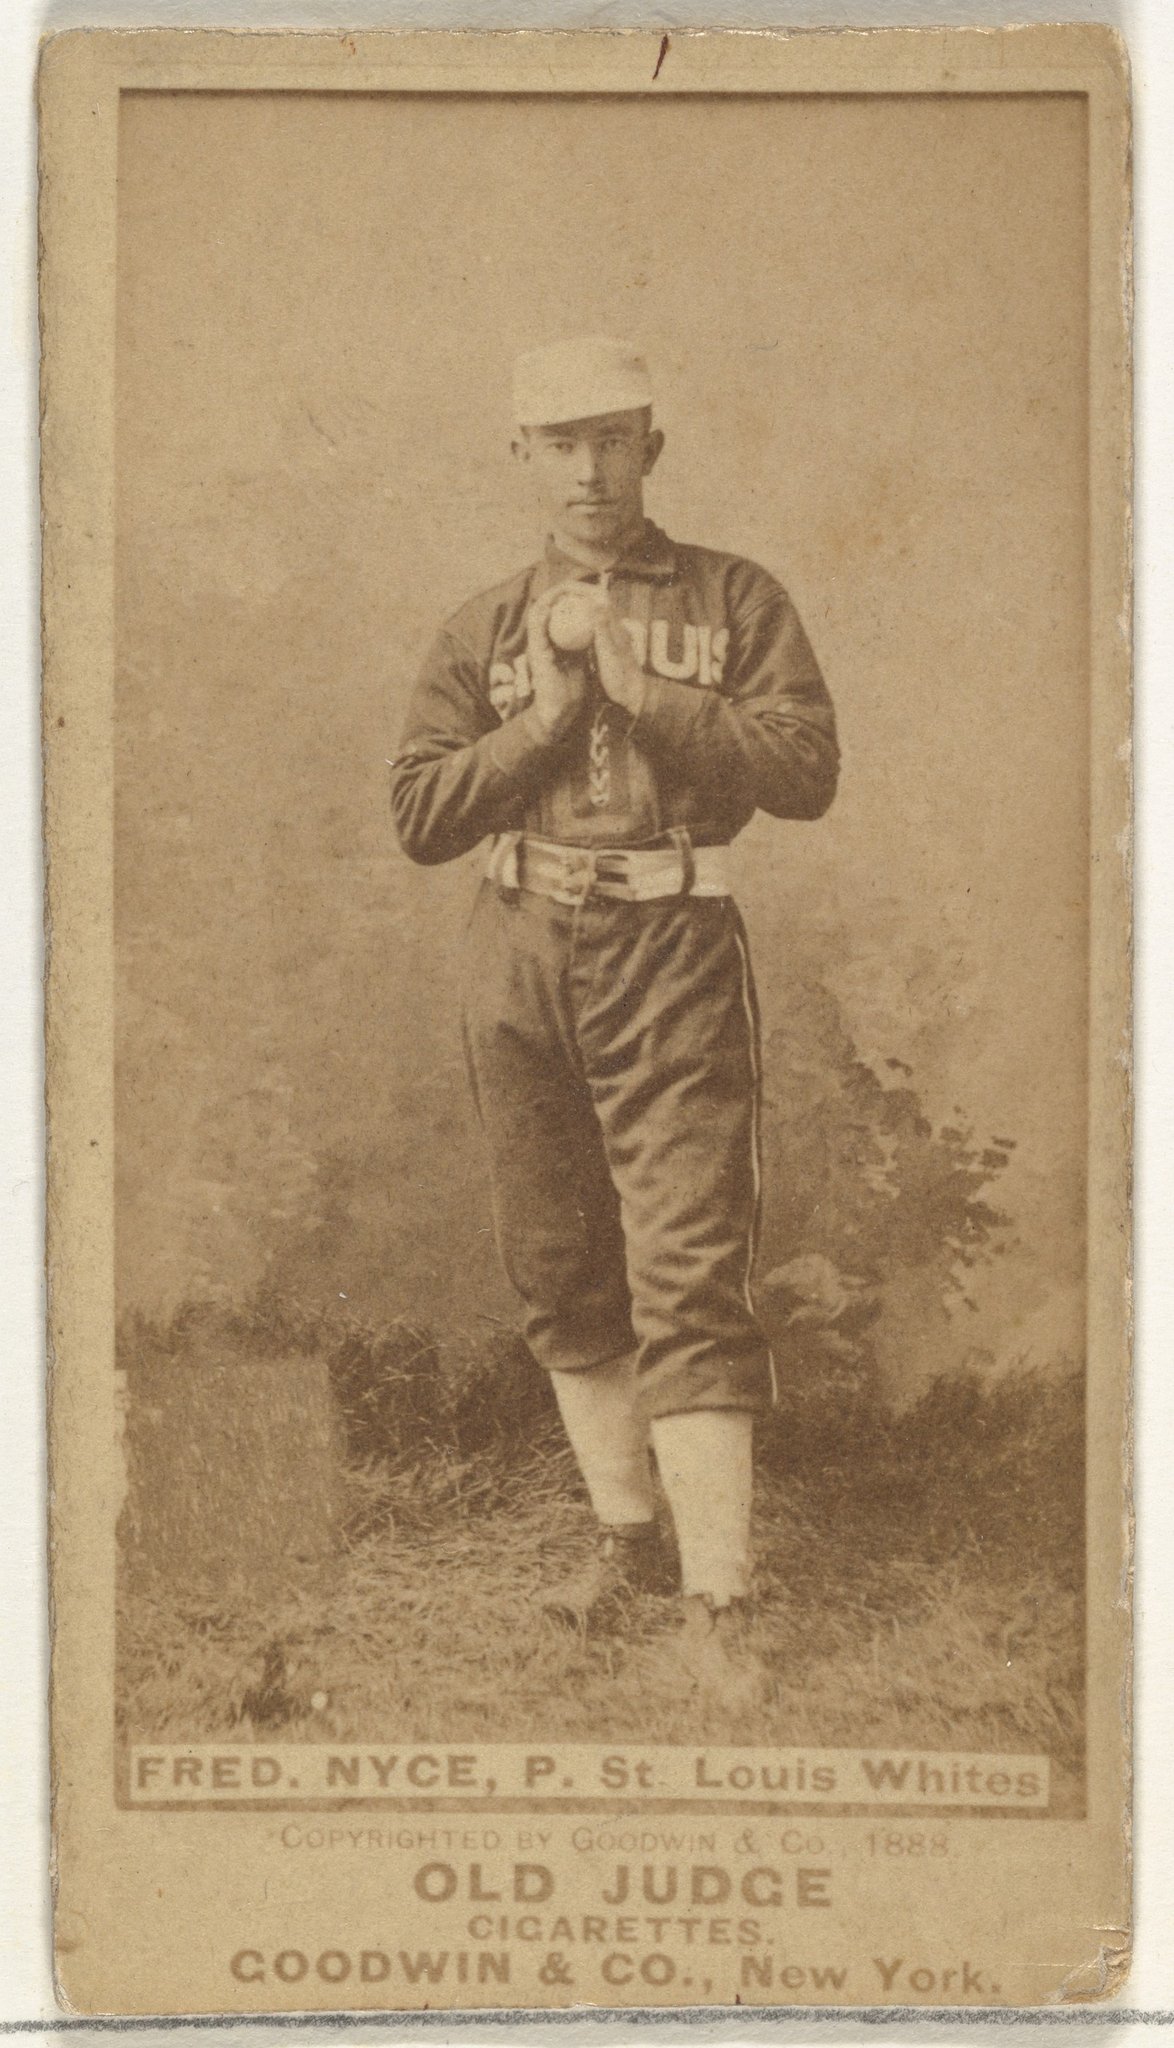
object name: baseball card, photograph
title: Nyce, Pitcher, St. Louis Whites, from the Old Judge series (N172) for Old Judge Cigarettes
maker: goodwin & company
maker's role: publisher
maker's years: 1850-1950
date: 1888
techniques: albumen silver print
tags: men,portraits,baseball,athletes